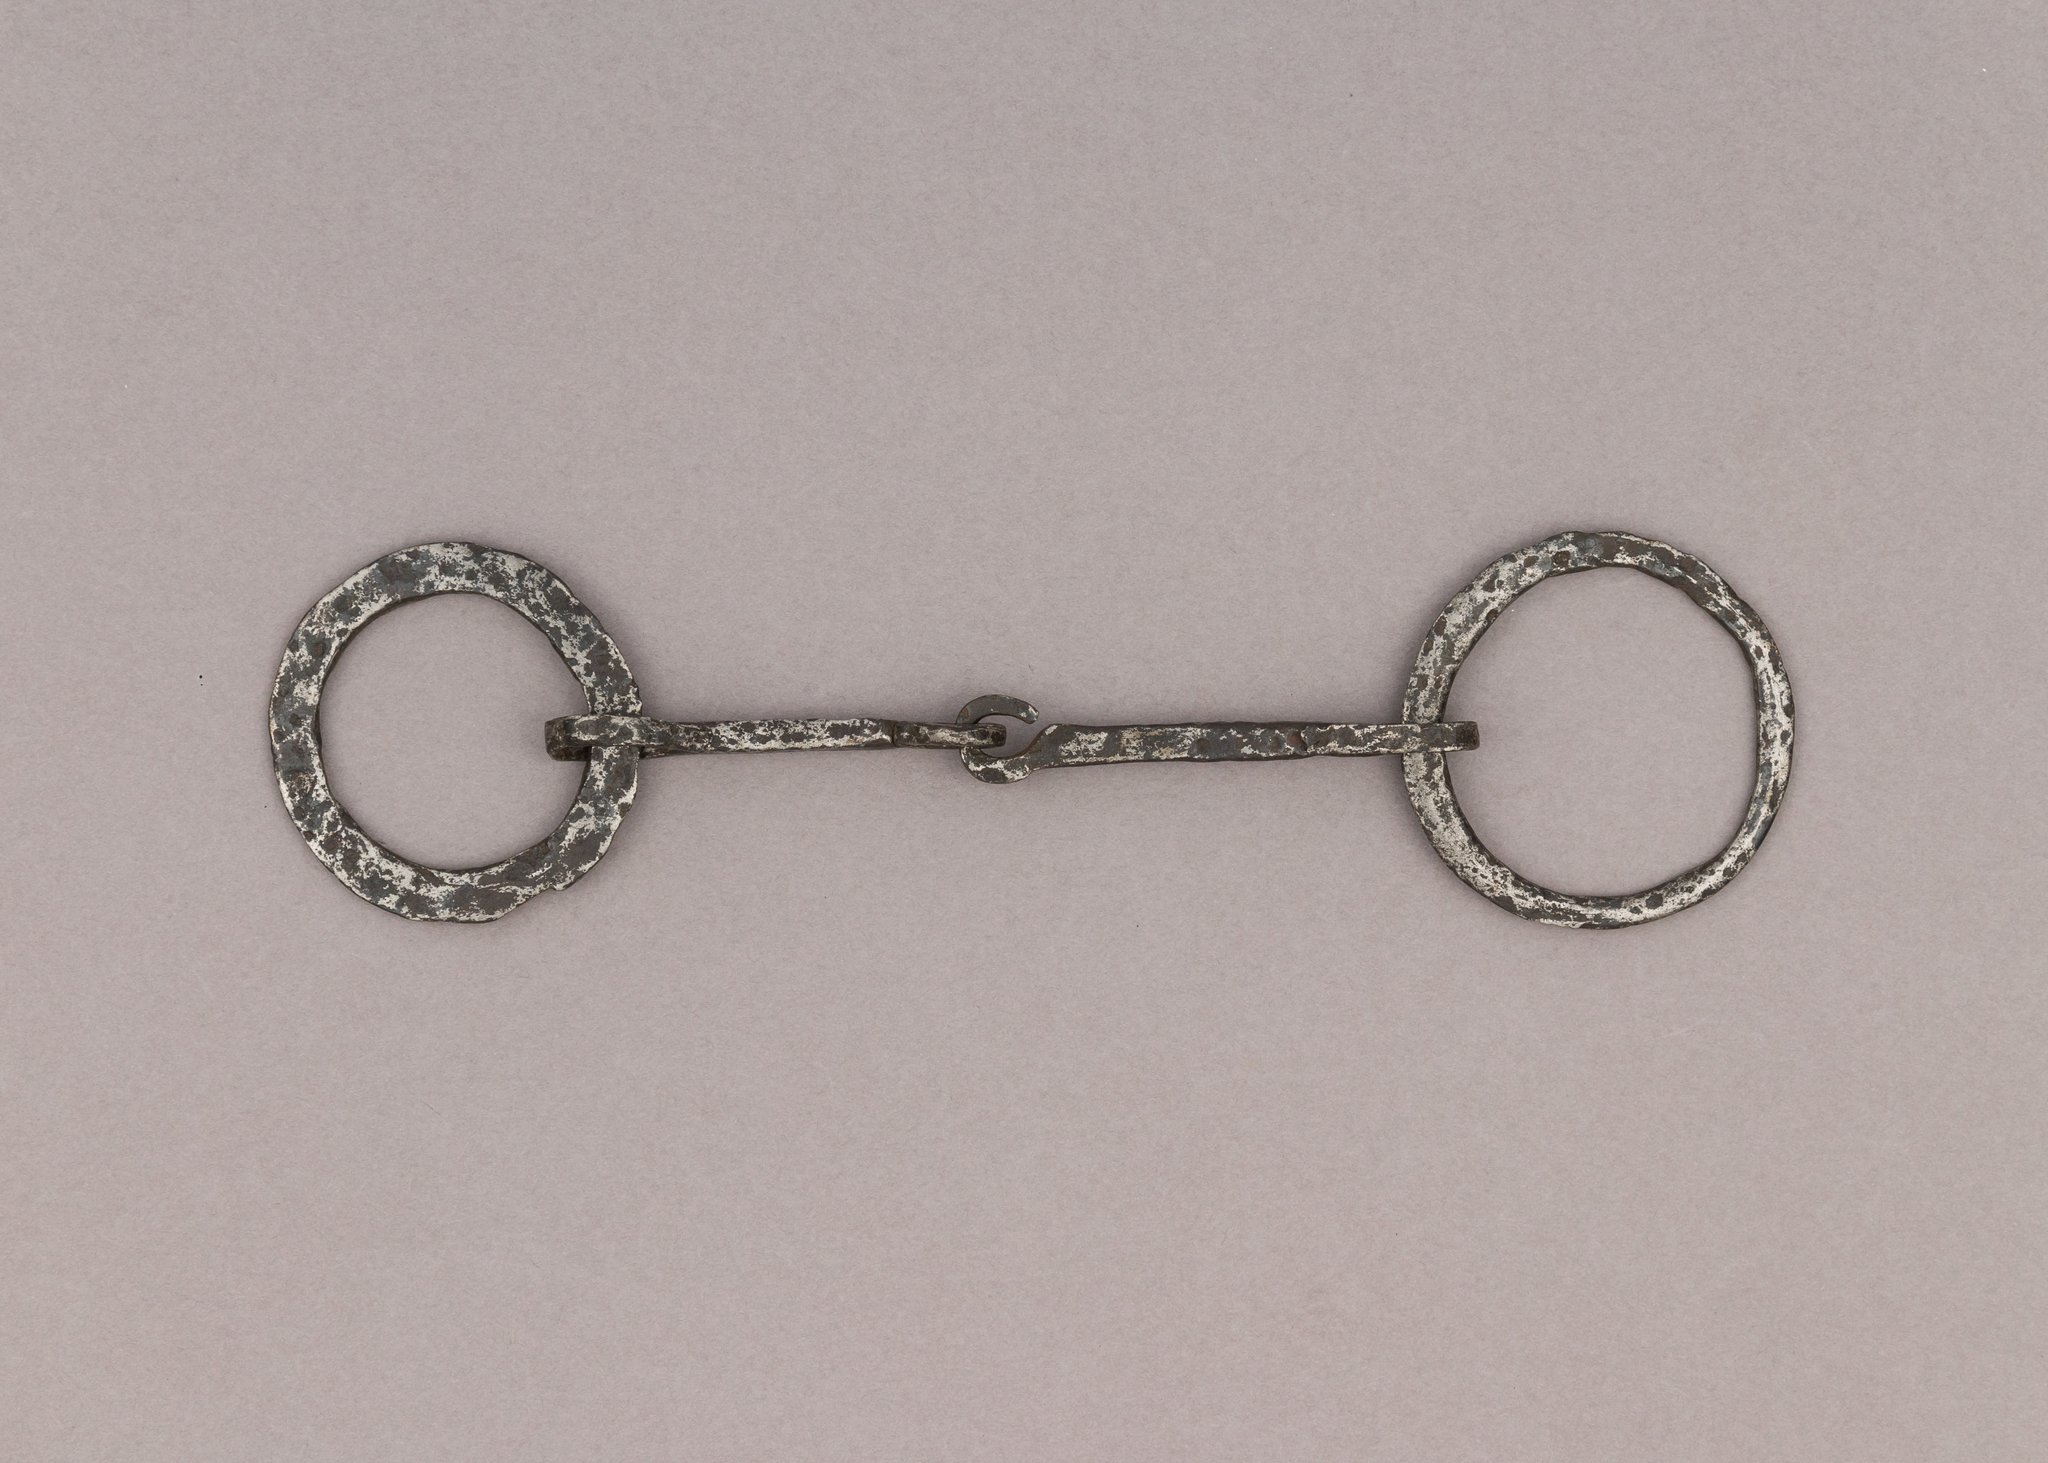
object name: bit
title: Snaffle Bit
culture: german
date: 801-1100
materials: iron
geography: poland